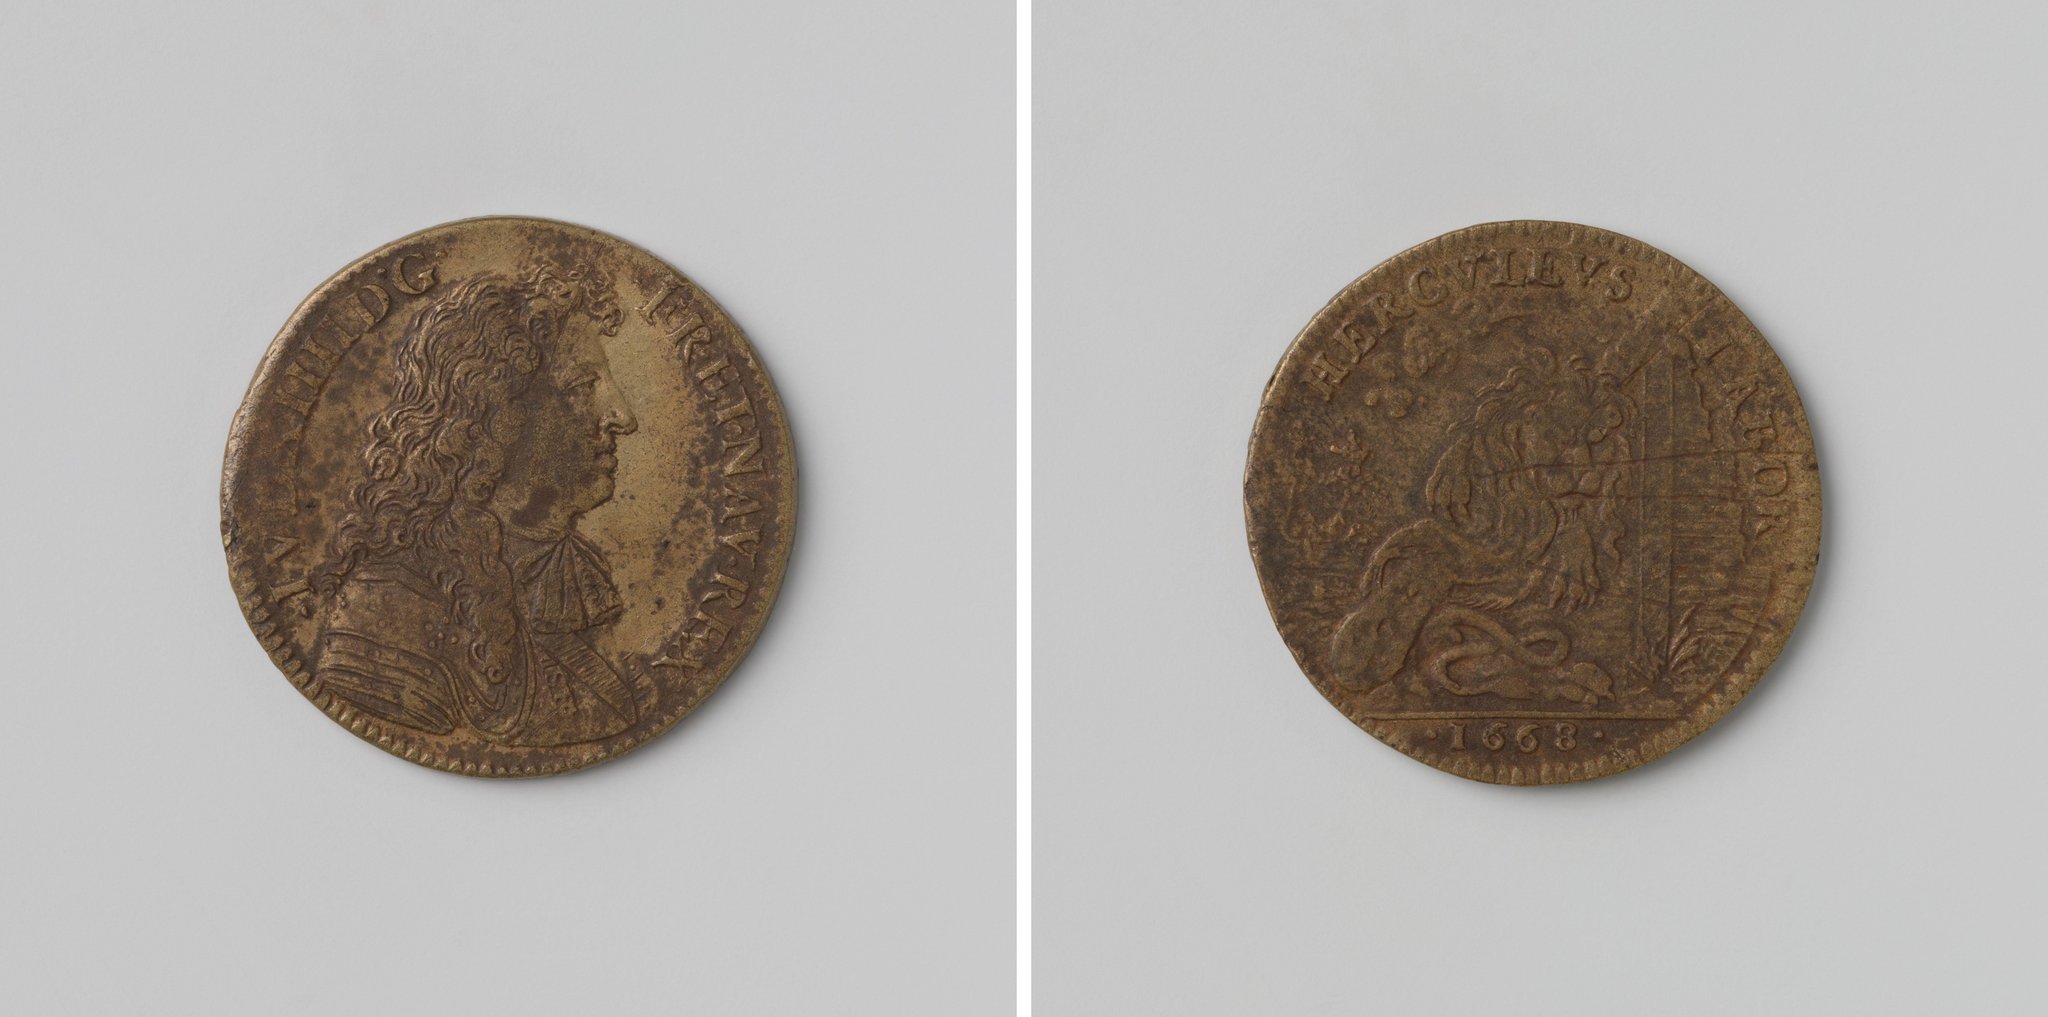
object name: jeton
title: Franche Comte in tien dagen veroverd, rekenpenning geslagen ter ere van Lodewijk XIV, koning van Frankrijk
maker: Anonymous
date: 1668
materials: copper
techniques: striking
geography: france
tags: lodewijk xiv (koning van frankrijk)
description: Koperen penning. Voorzijde: borststuk man binnen omschrift. Keerzijde: gestroopte leeuwehuid, hangend over tegen muur geleunde knots binnen omschrift; afsnede: jaartal